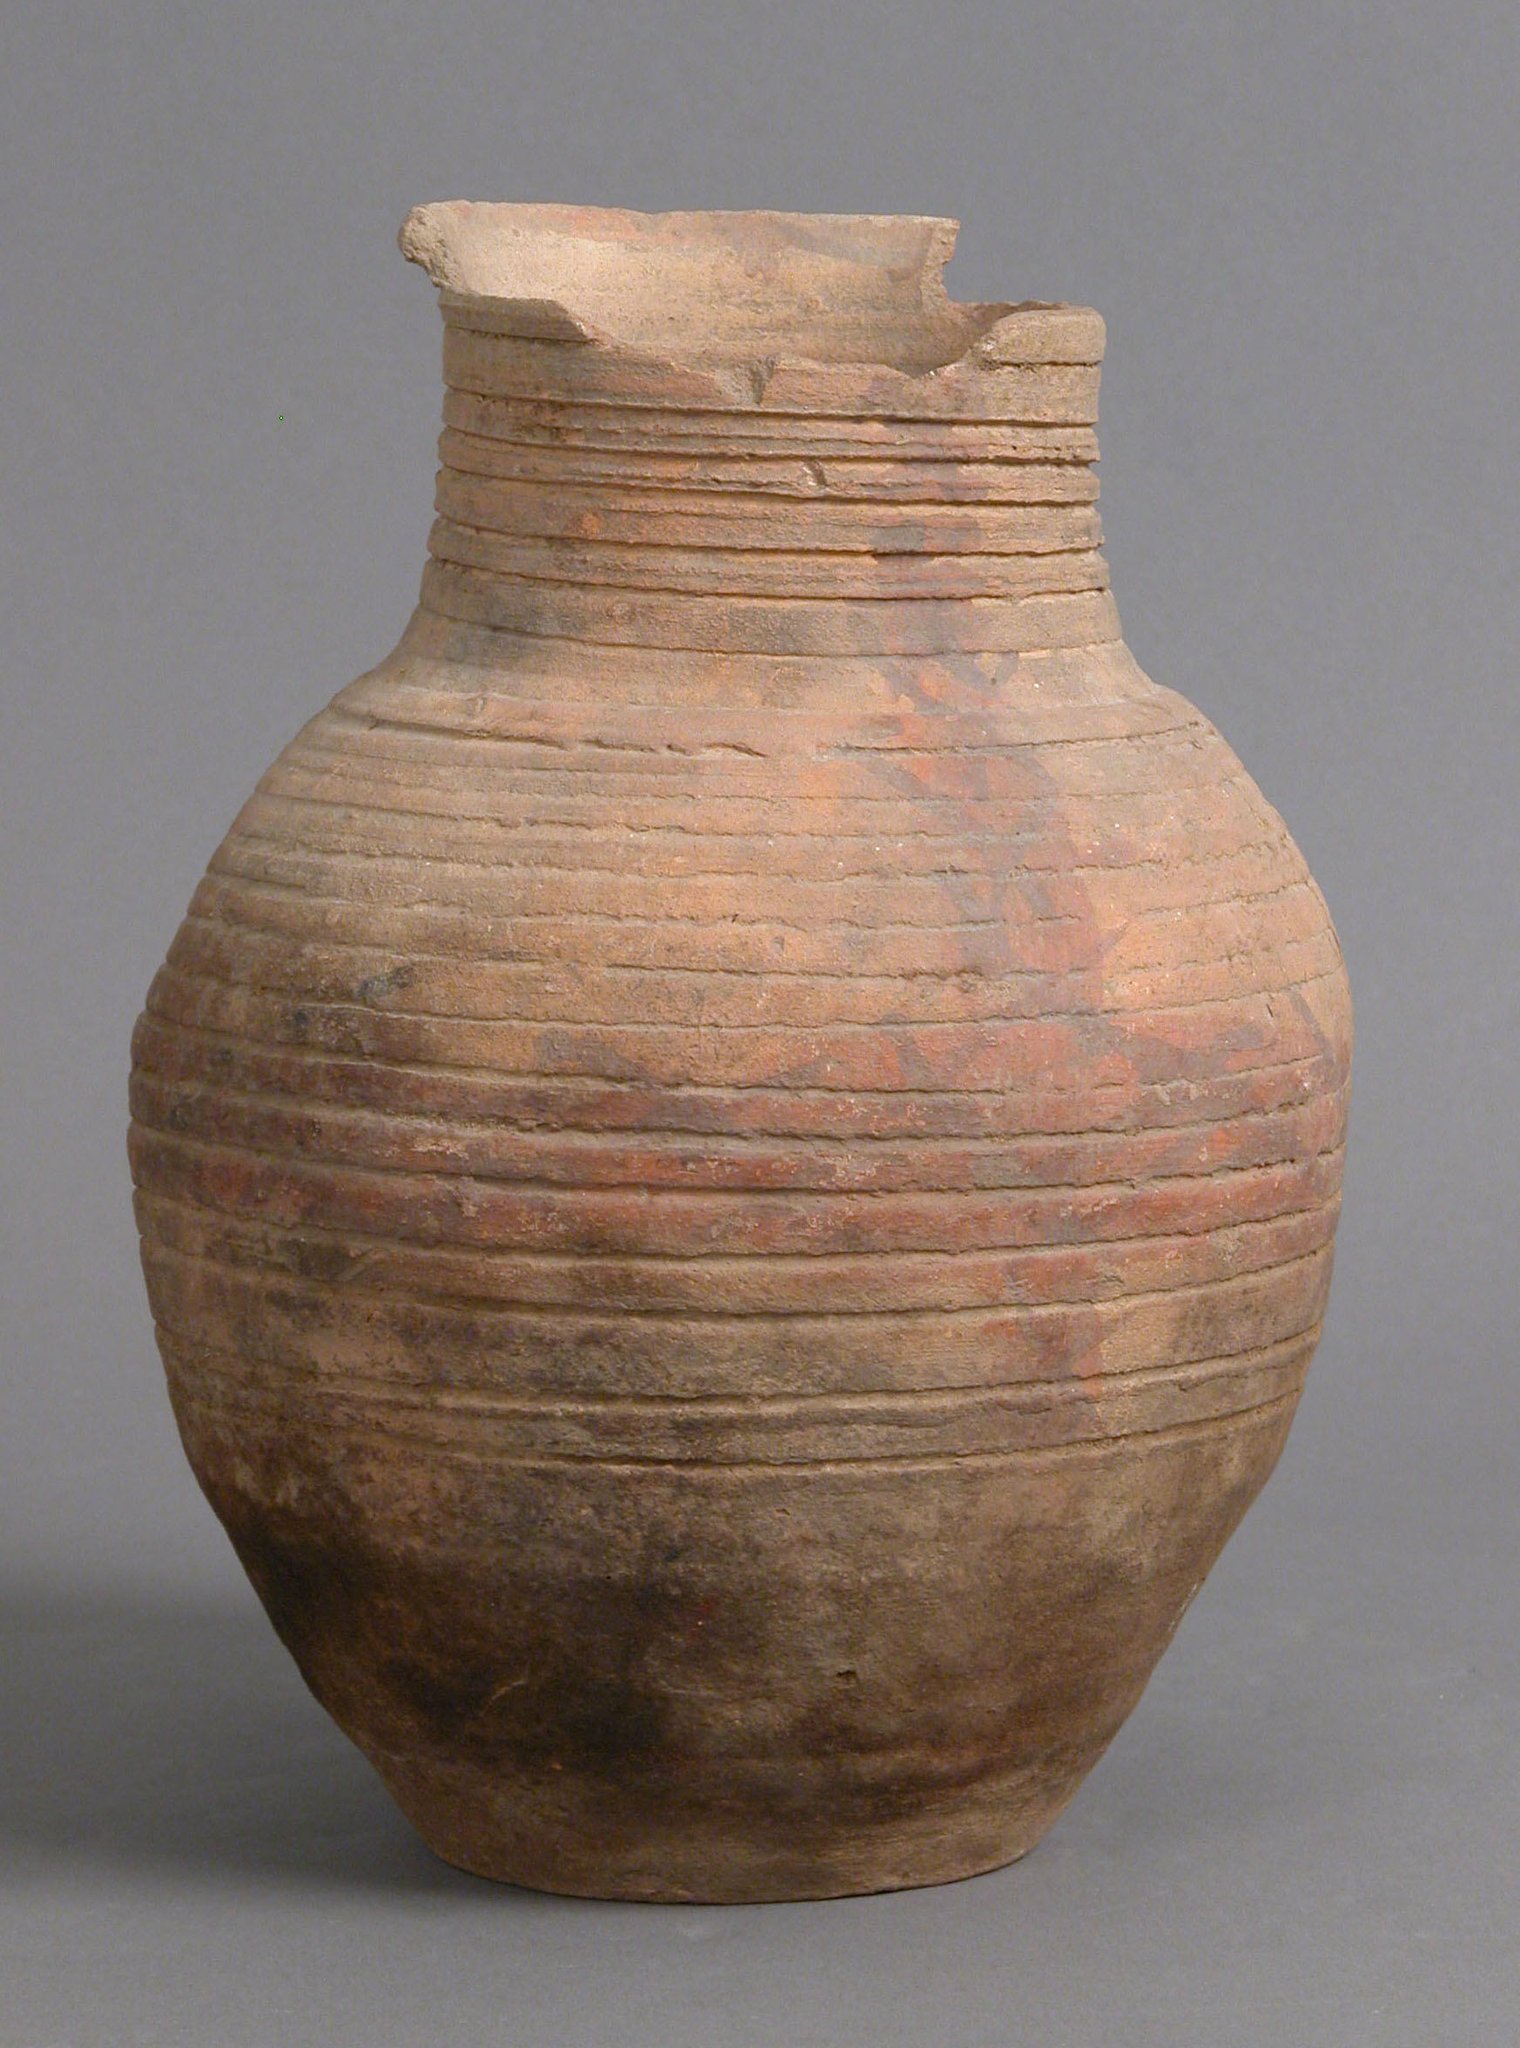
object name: amphora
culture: coptic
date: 301-700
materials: earthenware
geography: egypt